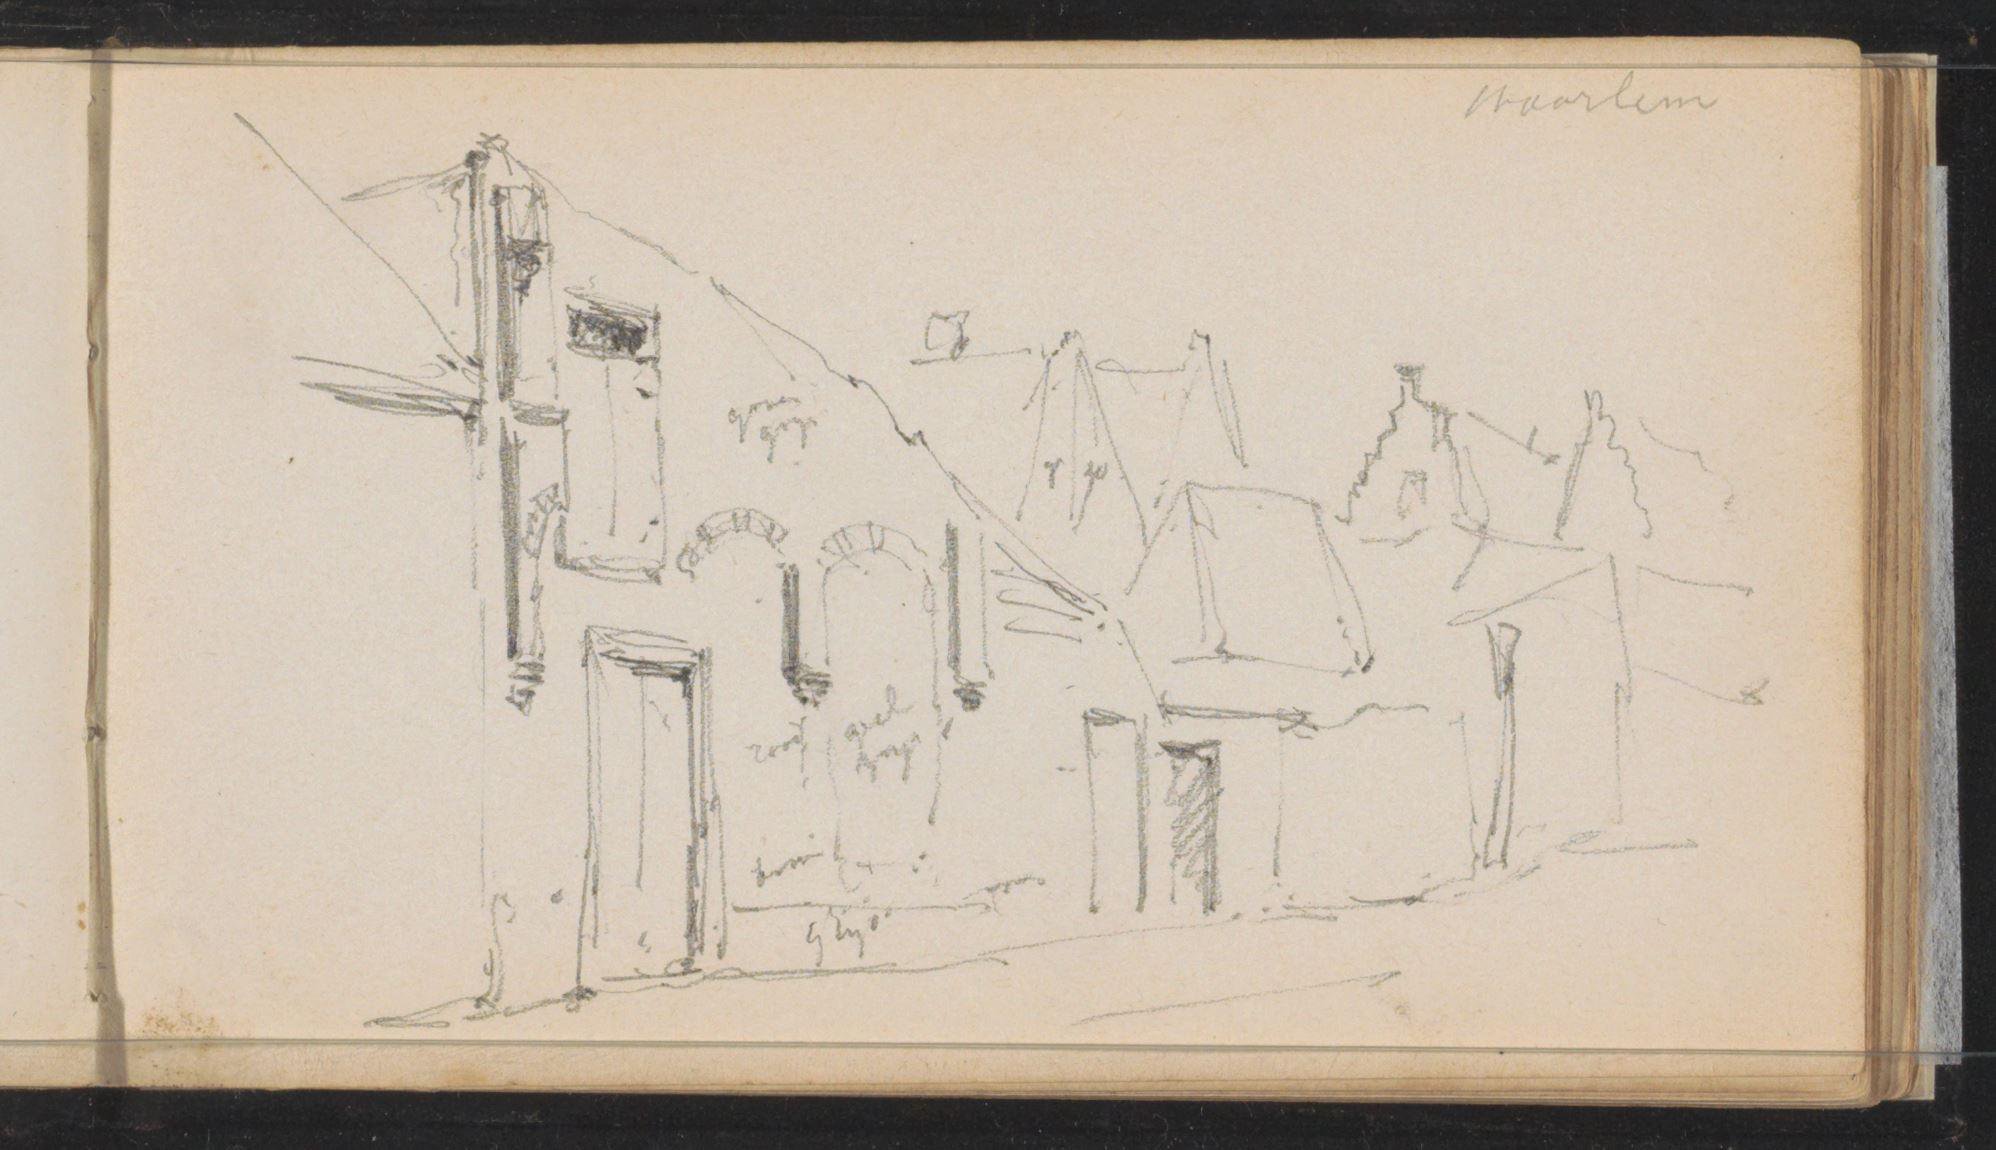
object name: sketchbook leaf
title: Gezicht in Haarlem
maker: cornelis springer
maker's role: draughtsman, painter, print maker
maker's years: 1817-1891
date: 1860-1866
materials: paper, pencil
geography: netherlands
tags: urban housing, street, haarlem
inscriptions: annotation: ‘Haarlem’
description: Gezicht op een straat in Haarlem. Blad 21 uit een schetsboek met 44 bladen.